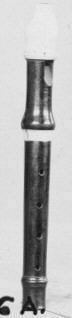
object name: flageolet in f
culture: french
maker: millet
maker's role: maker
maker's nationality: possibly french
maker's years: 1800-1850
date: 1801-1900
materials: ivory, wood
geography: france